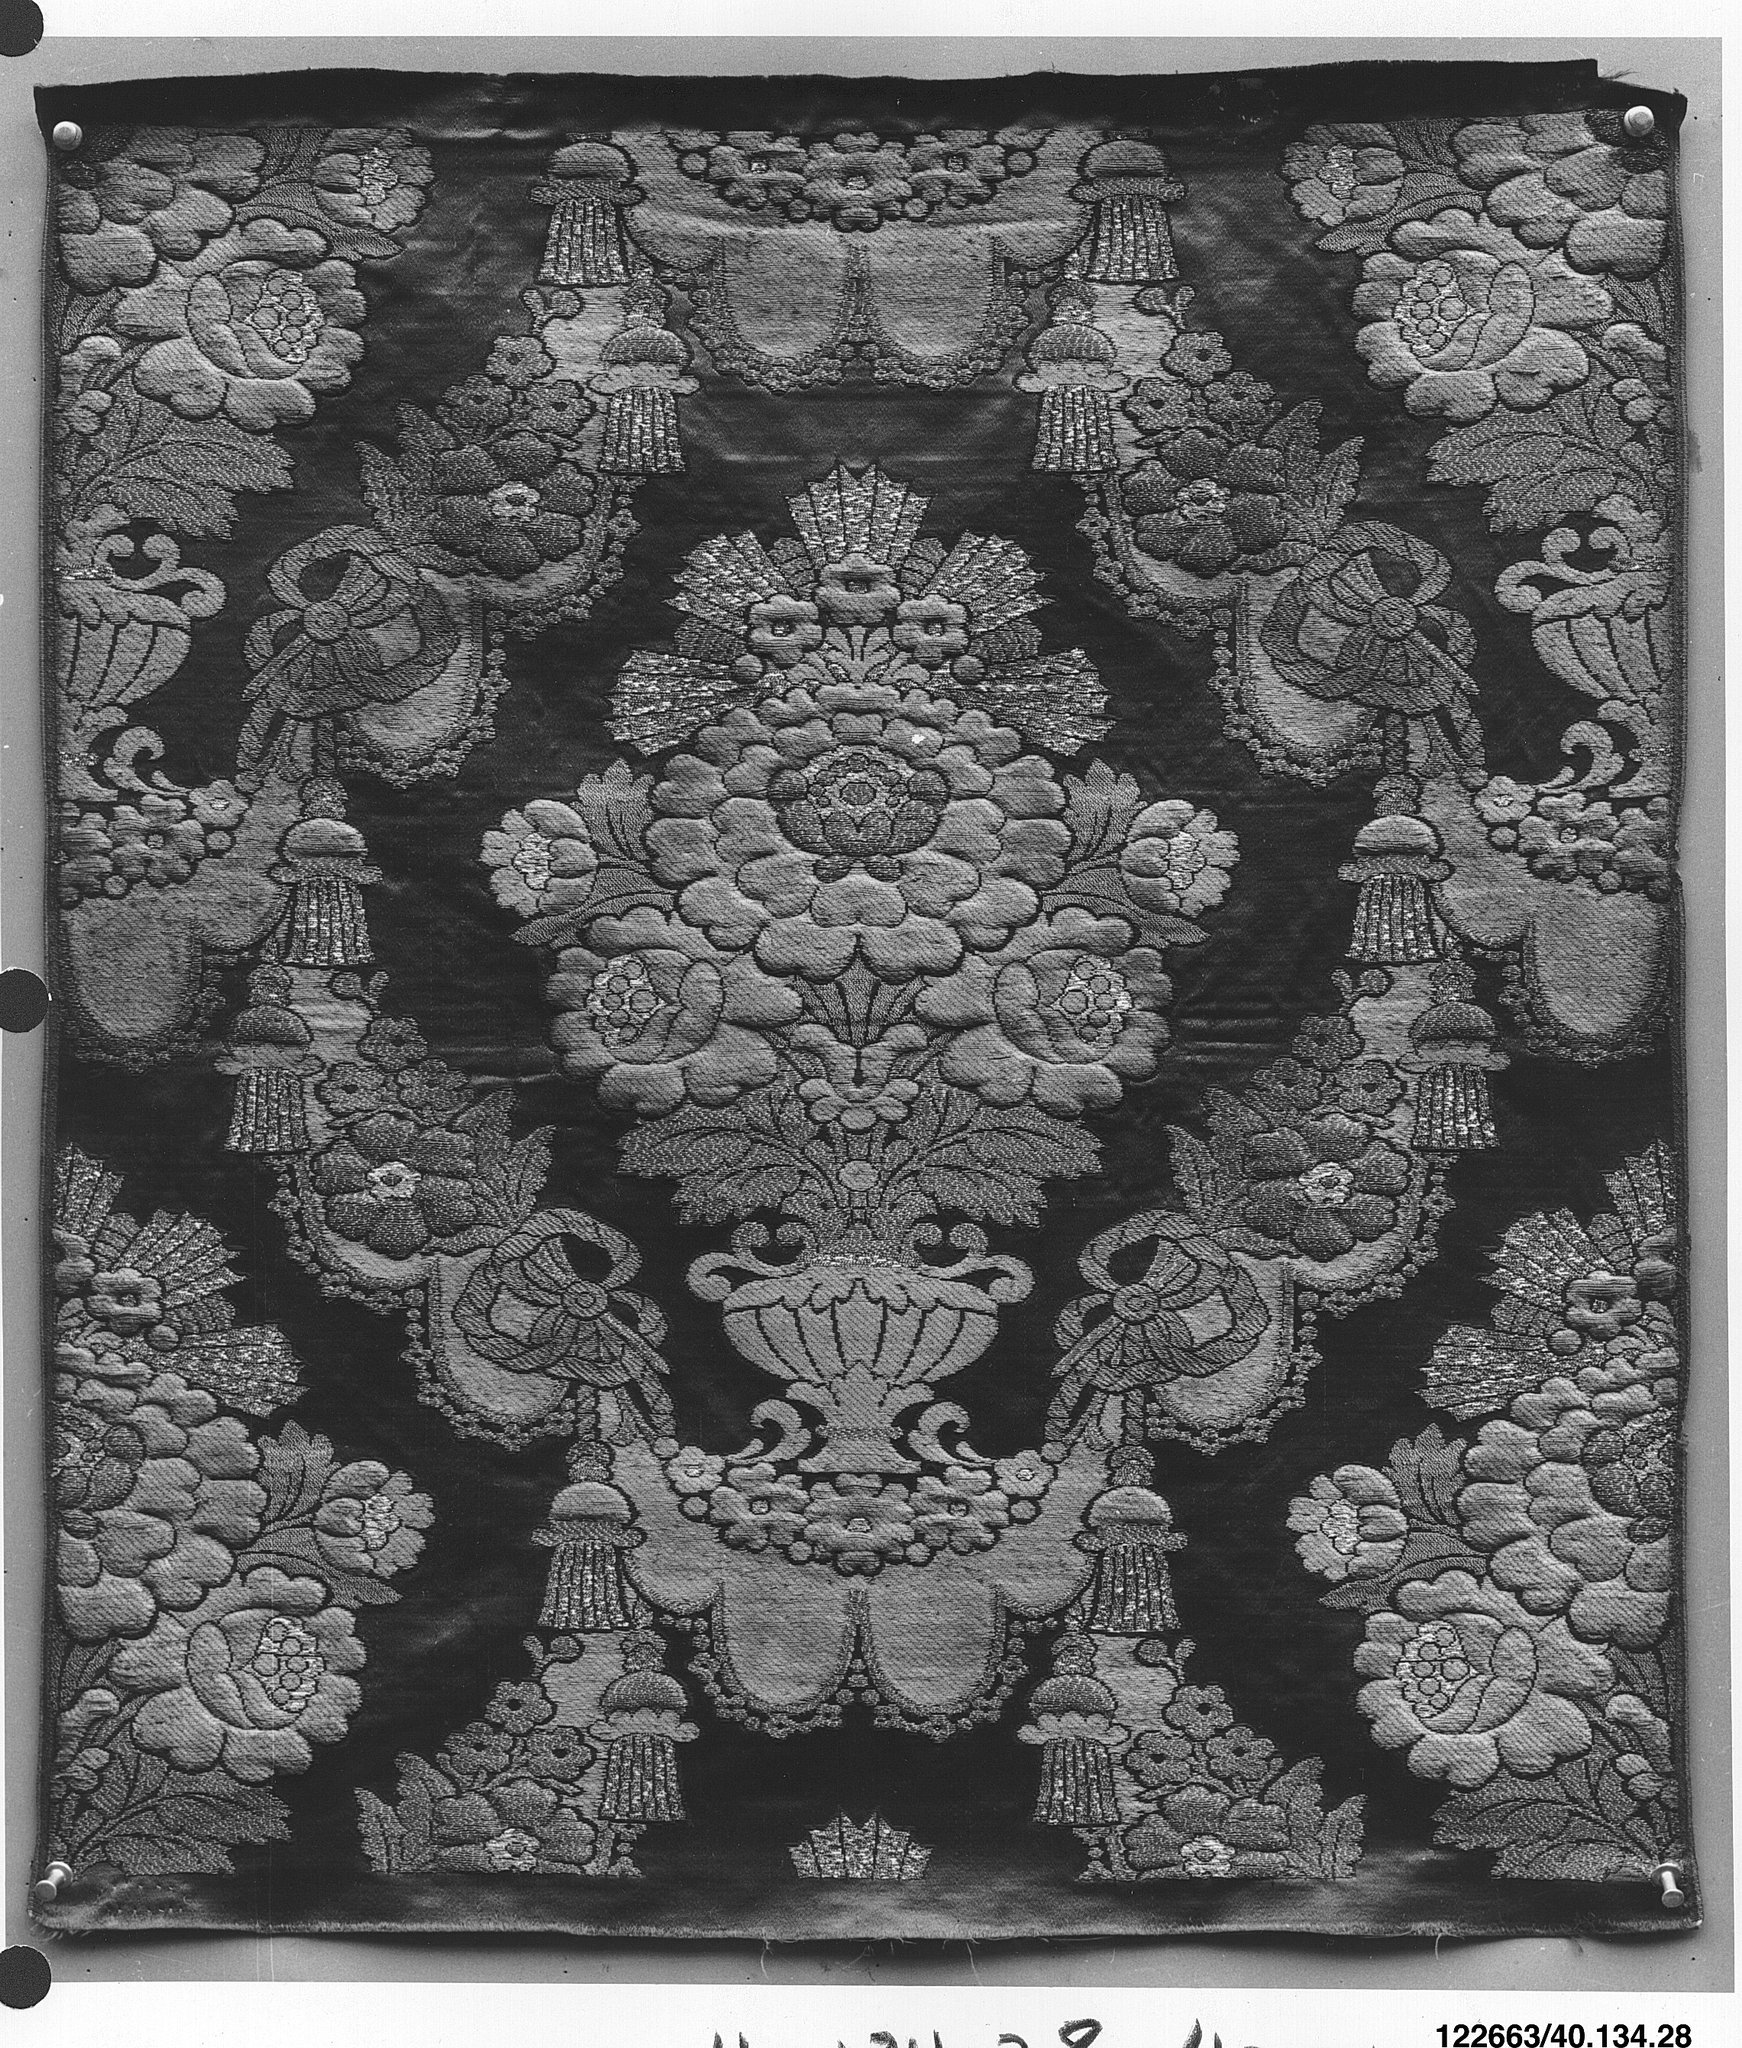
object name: piece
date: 1701-1900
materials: metal thread, silk, wool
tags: flowers,leaves